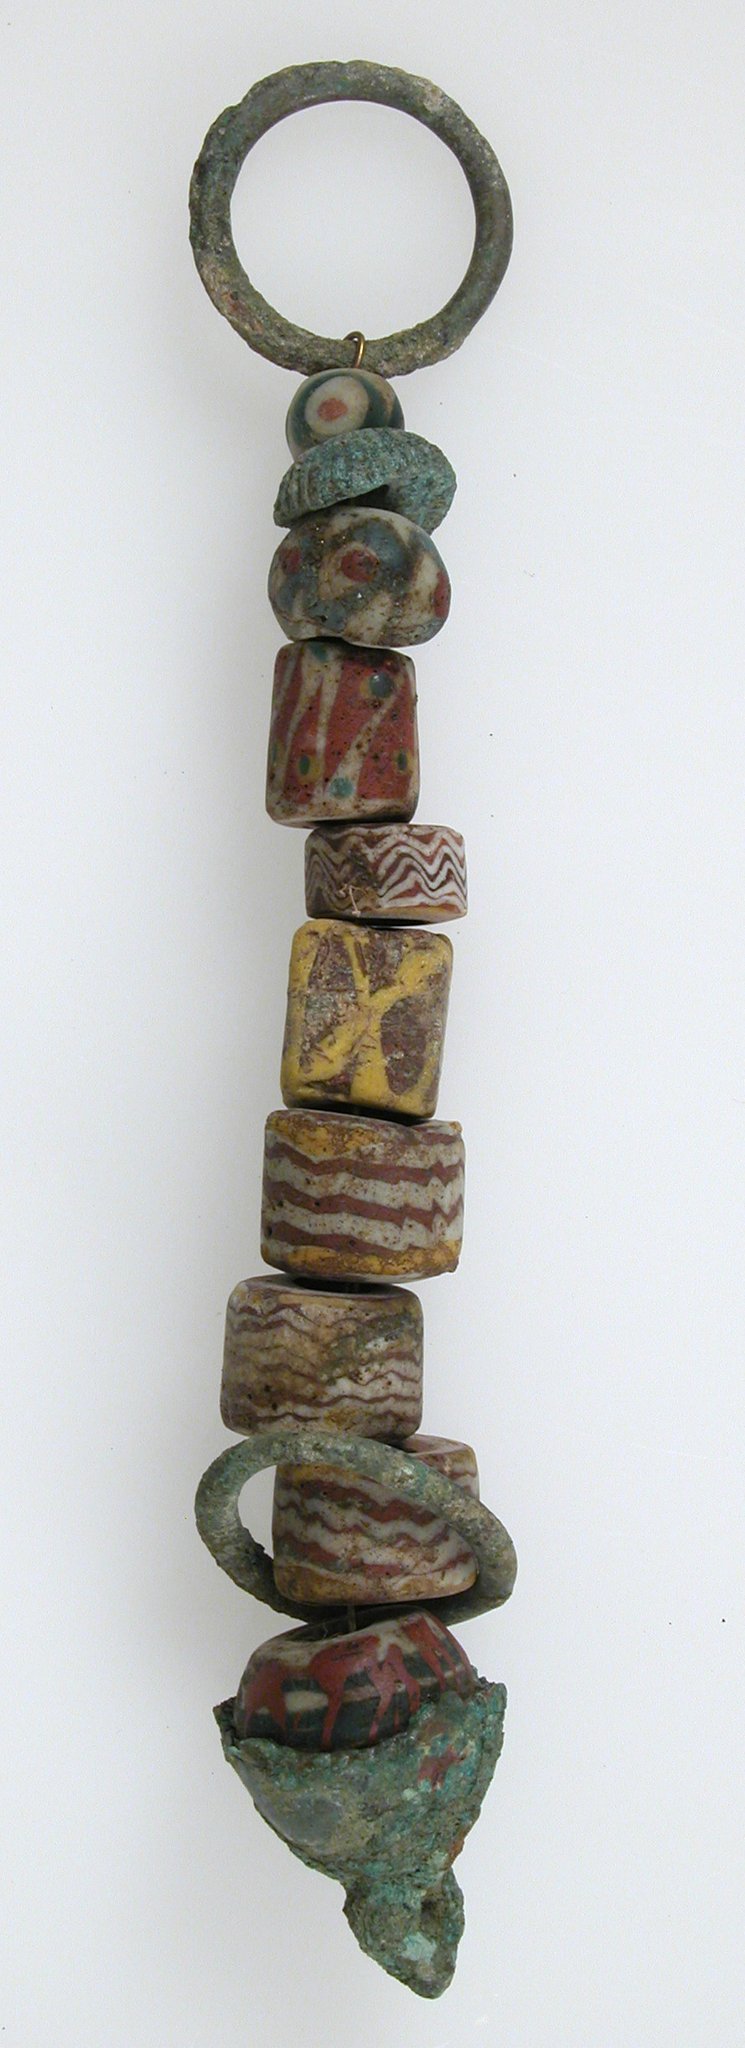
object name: pendant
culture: frankish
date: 500-600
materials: copper alloy, glass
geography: germany